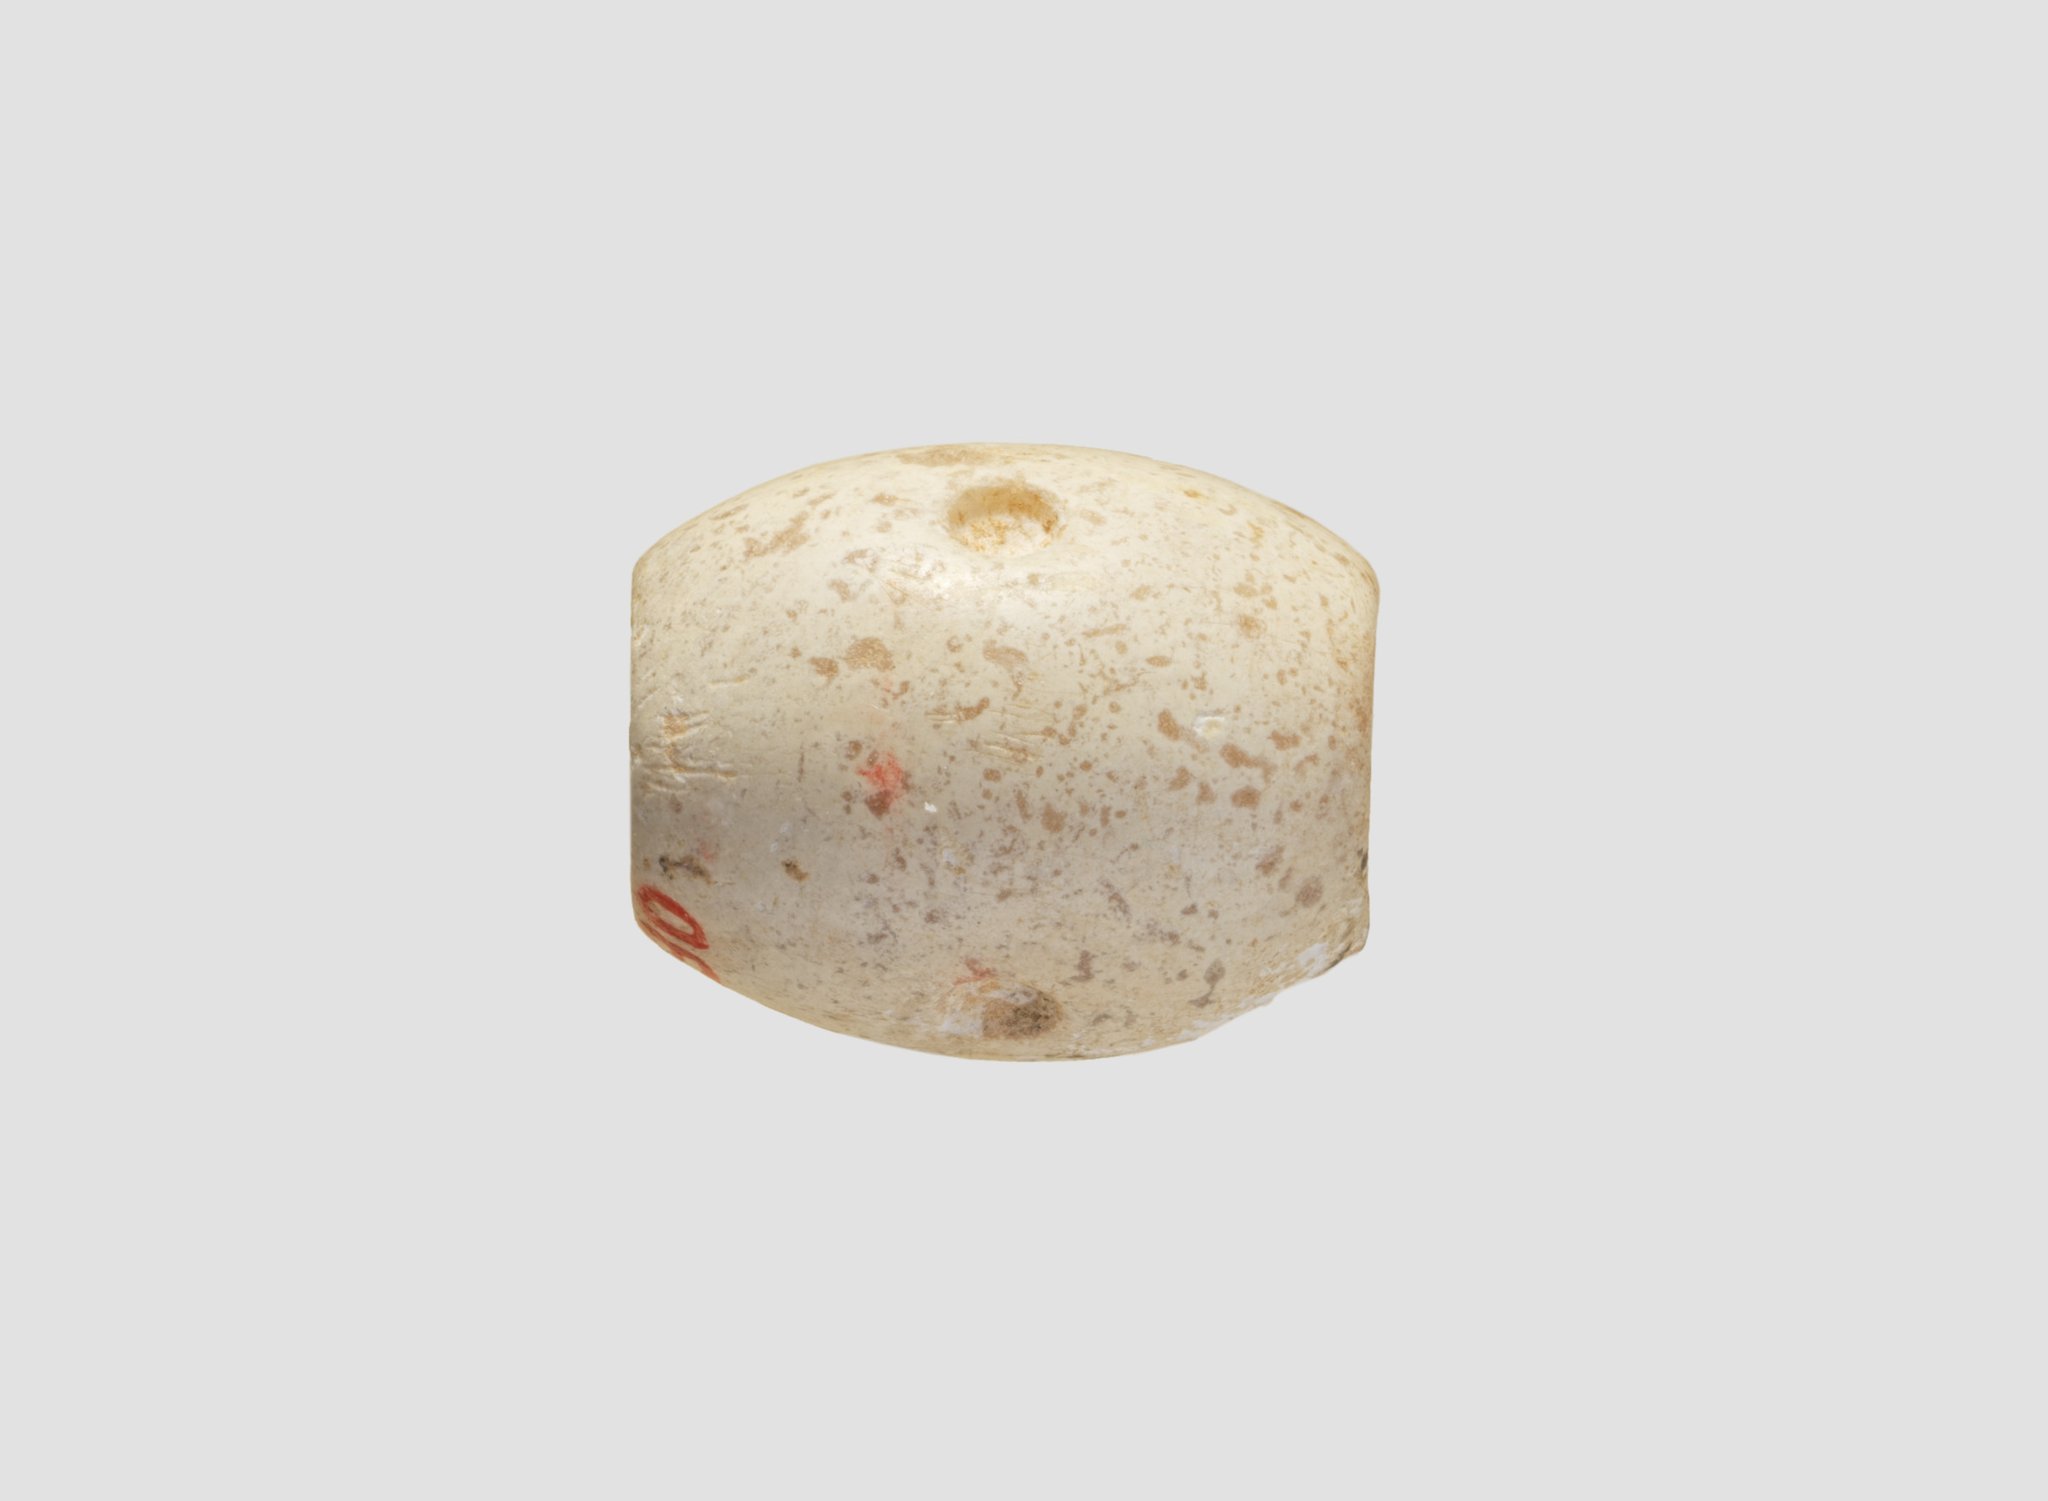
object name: bead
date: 2000-1668 BCE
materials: marble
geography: mesopotamia